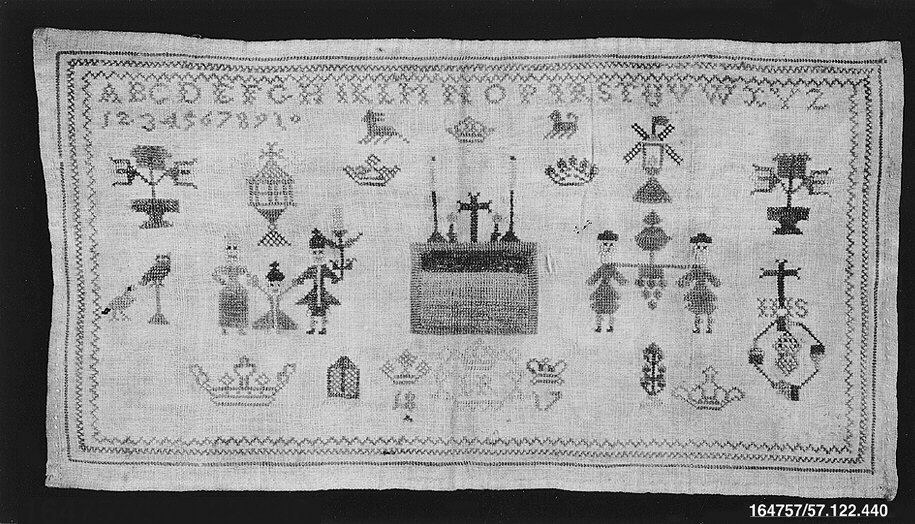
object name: sampler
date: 1817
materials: cotton, linen, silk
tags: human figures,animals,cross